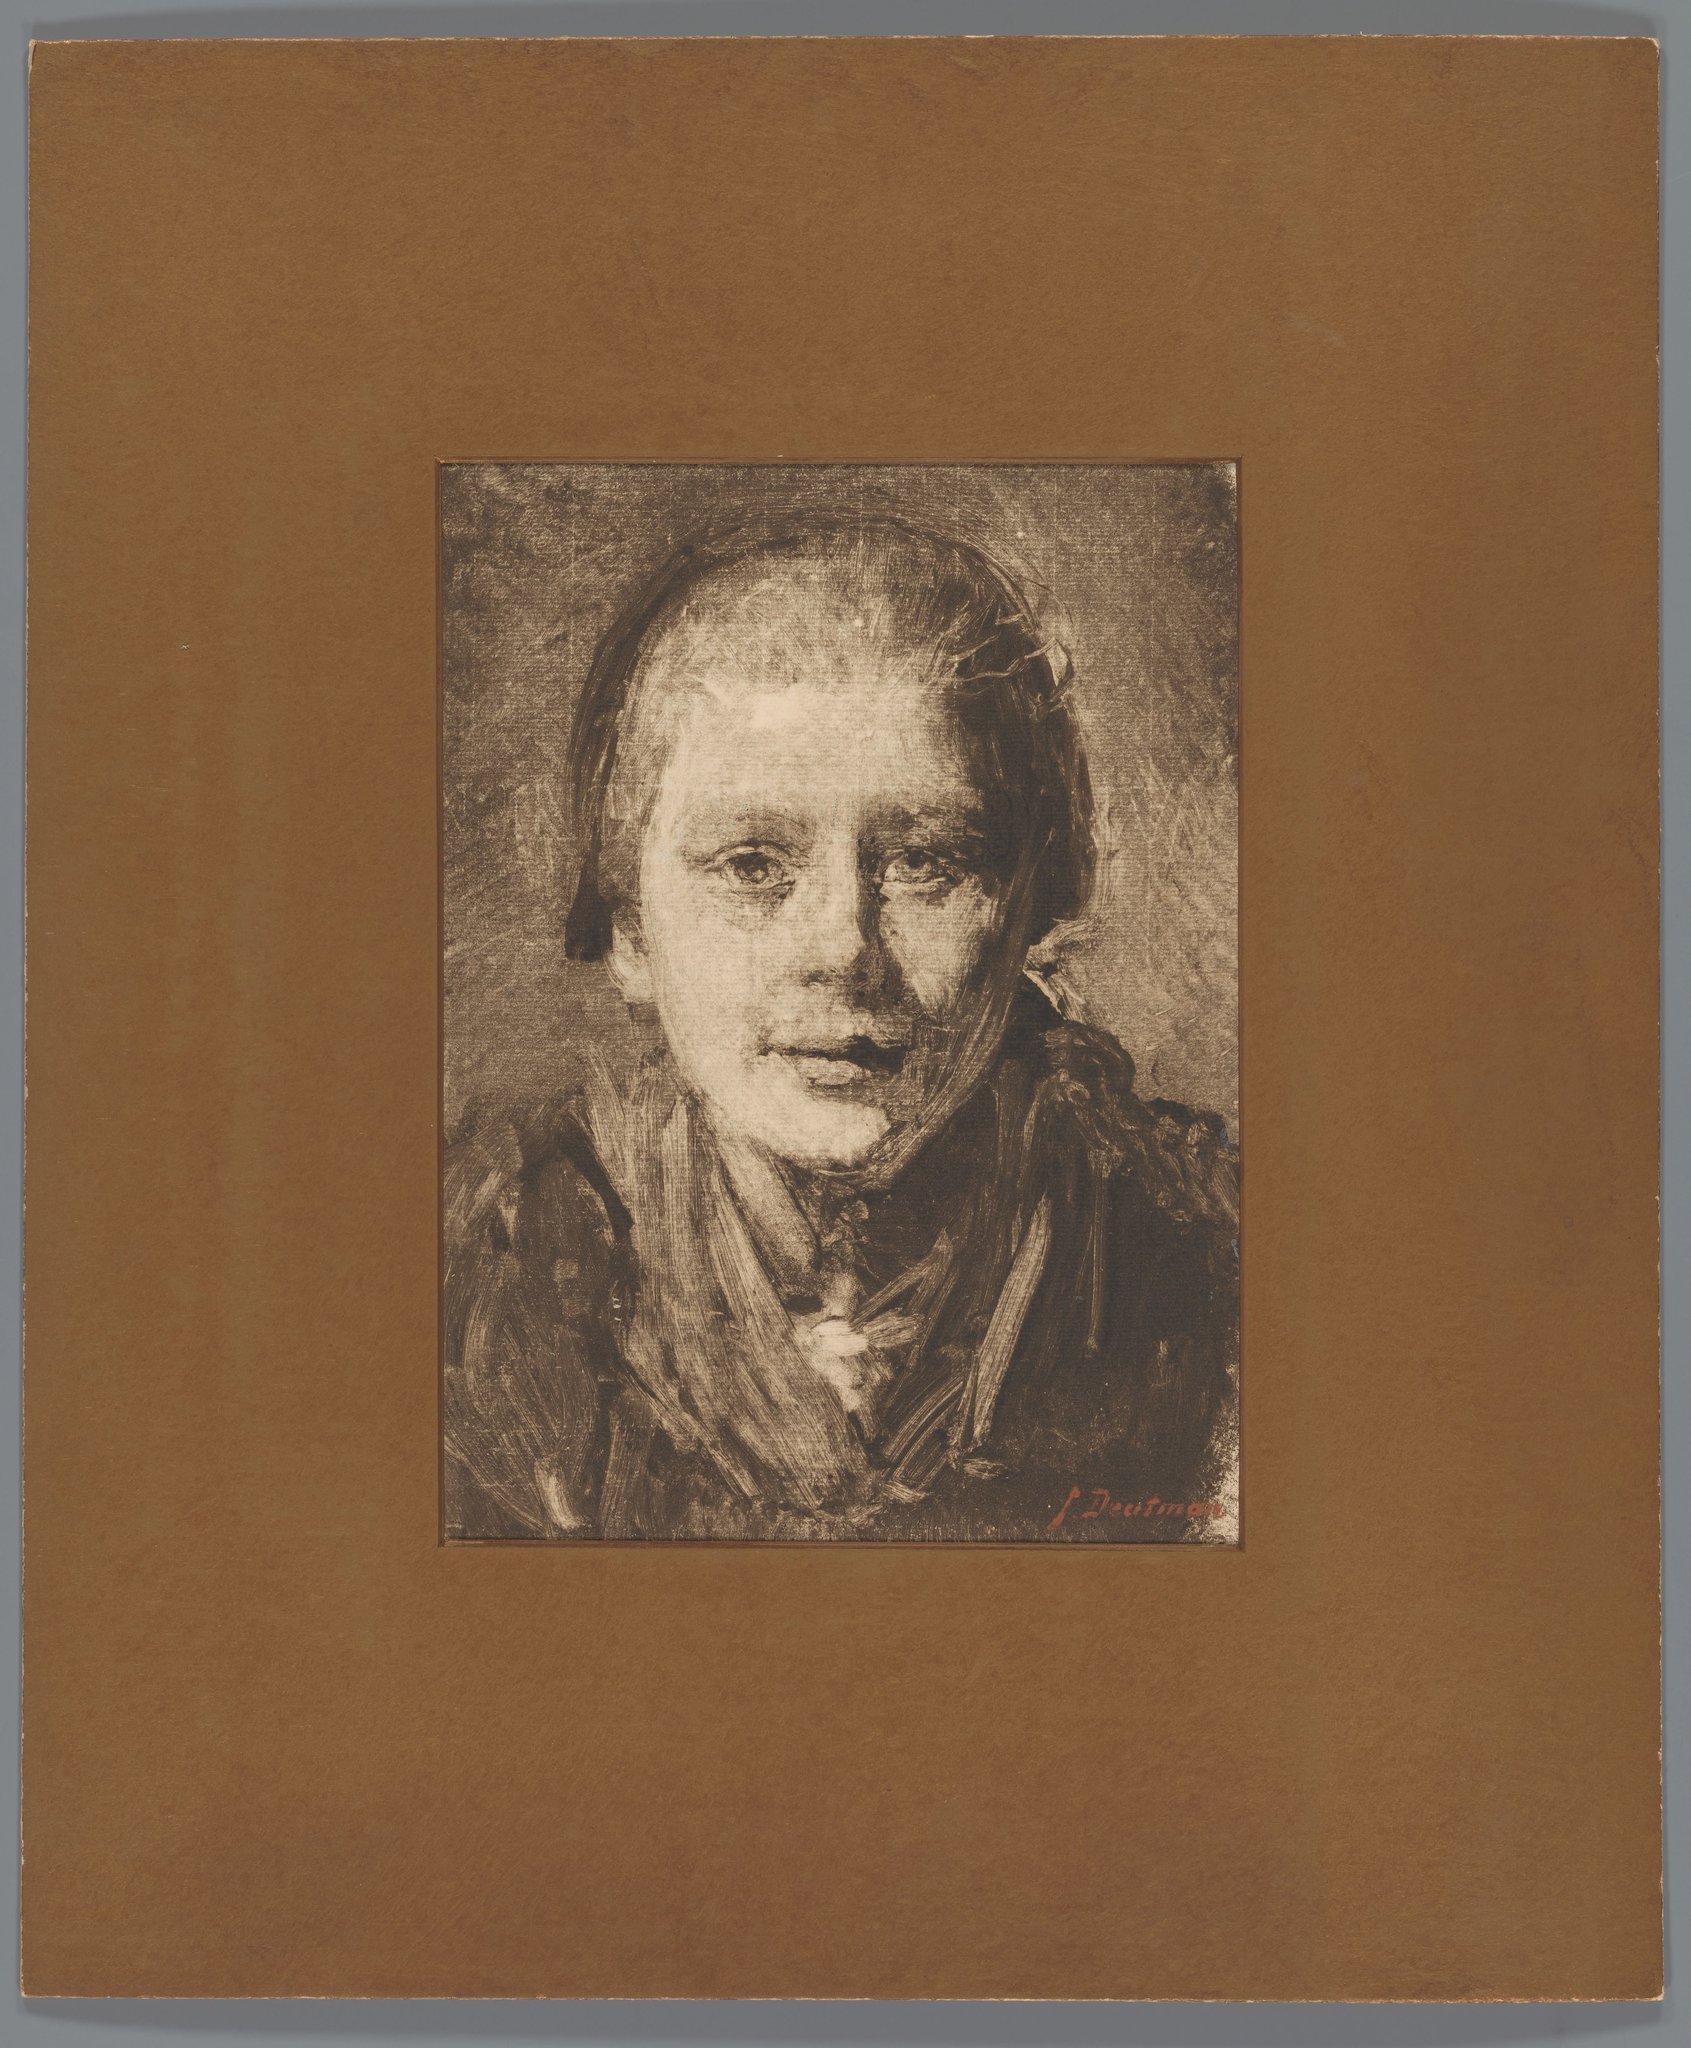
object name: print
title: Portret van onbekende jonge vrouw met kapje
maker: frans deutmann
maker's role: draughtsman, painter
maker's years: 1867-1915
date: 1877-1915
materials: paper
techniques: monotype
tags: anonymous historical person portrayed alone - bb - woman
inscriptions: collector's mark: Lugt 2233